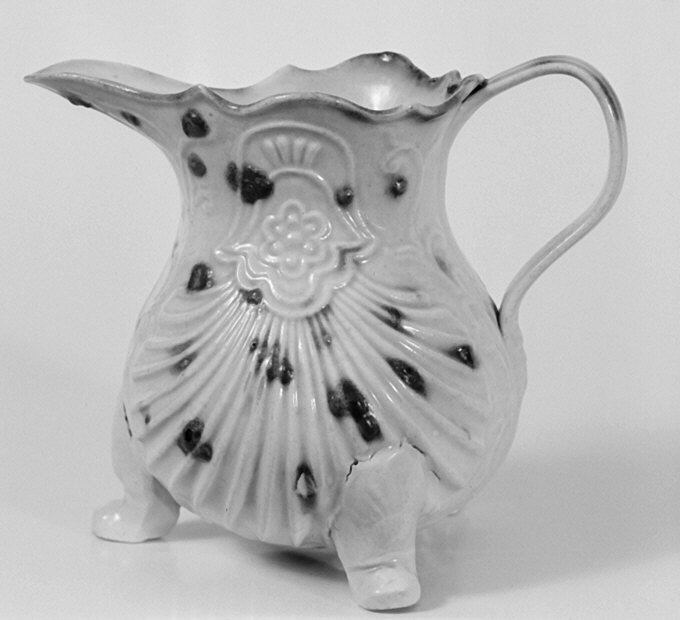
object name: cream jug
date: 1750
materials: stoneware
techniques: salt glaze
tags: flowers